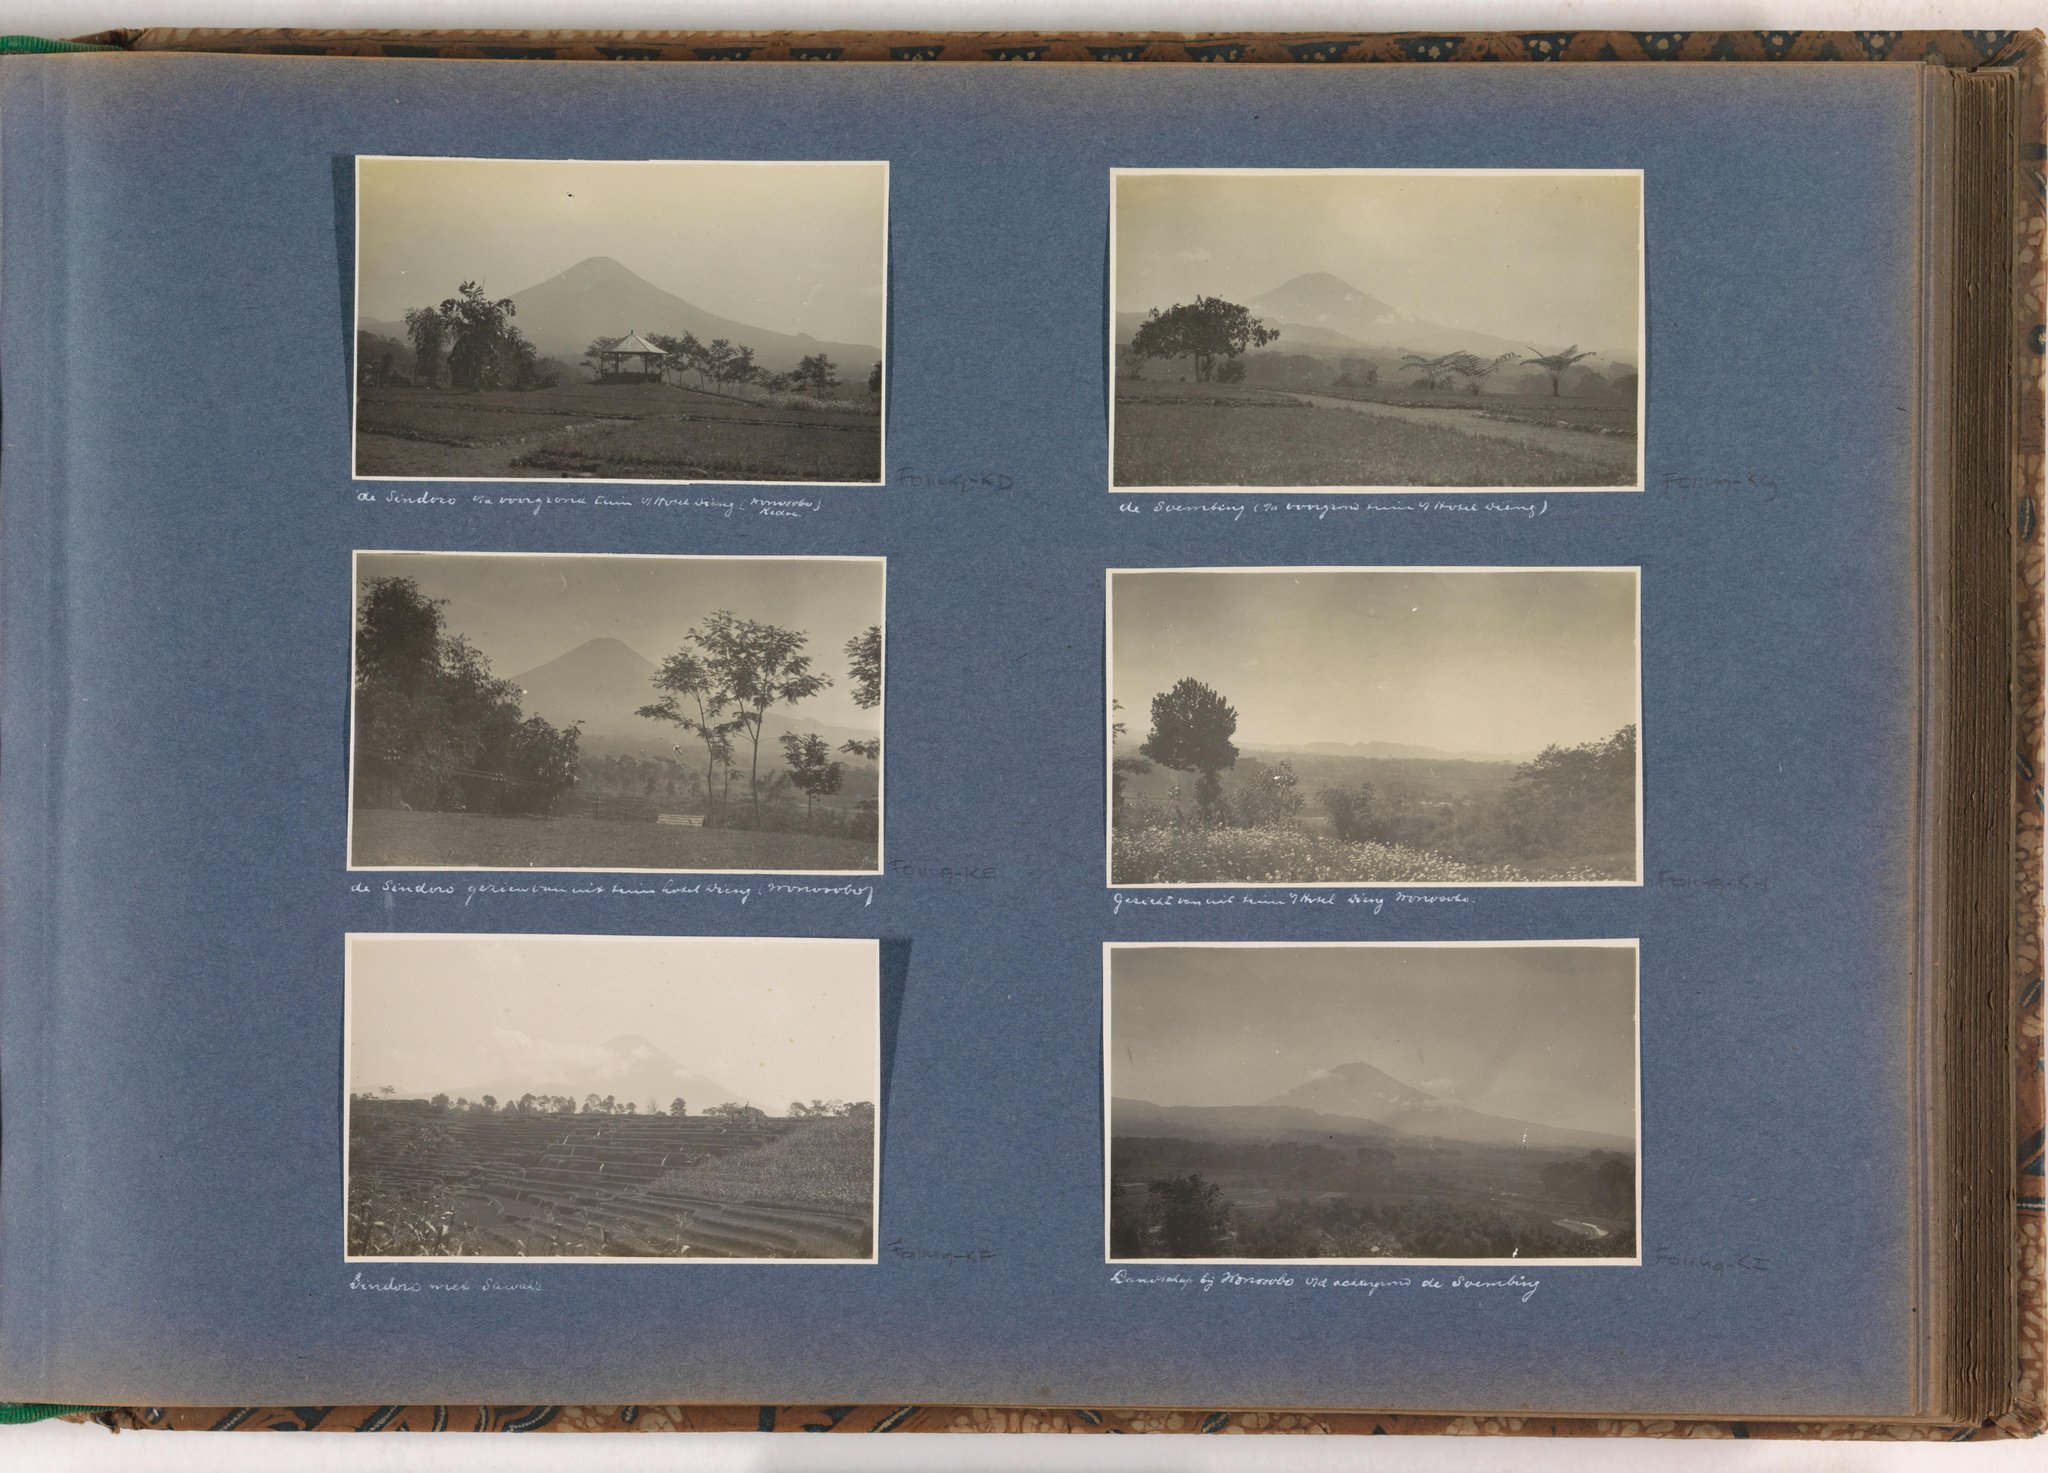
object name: photograph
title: Vulkaan Sumbing op Java gezien vanuit de voortuin van Hotel Dieng in Wonosobo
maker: Anonymous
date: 1900-1920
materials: paper, photographic support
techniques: gelatin silver print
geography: java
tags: volcano, hotel, hostelry, inn, java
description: Onderdeel van reisalbum met foto's van bedrijvigheid en bezienswaardigheden op Sumatra en Java en van de reis naar en van Nederlands-Indië.